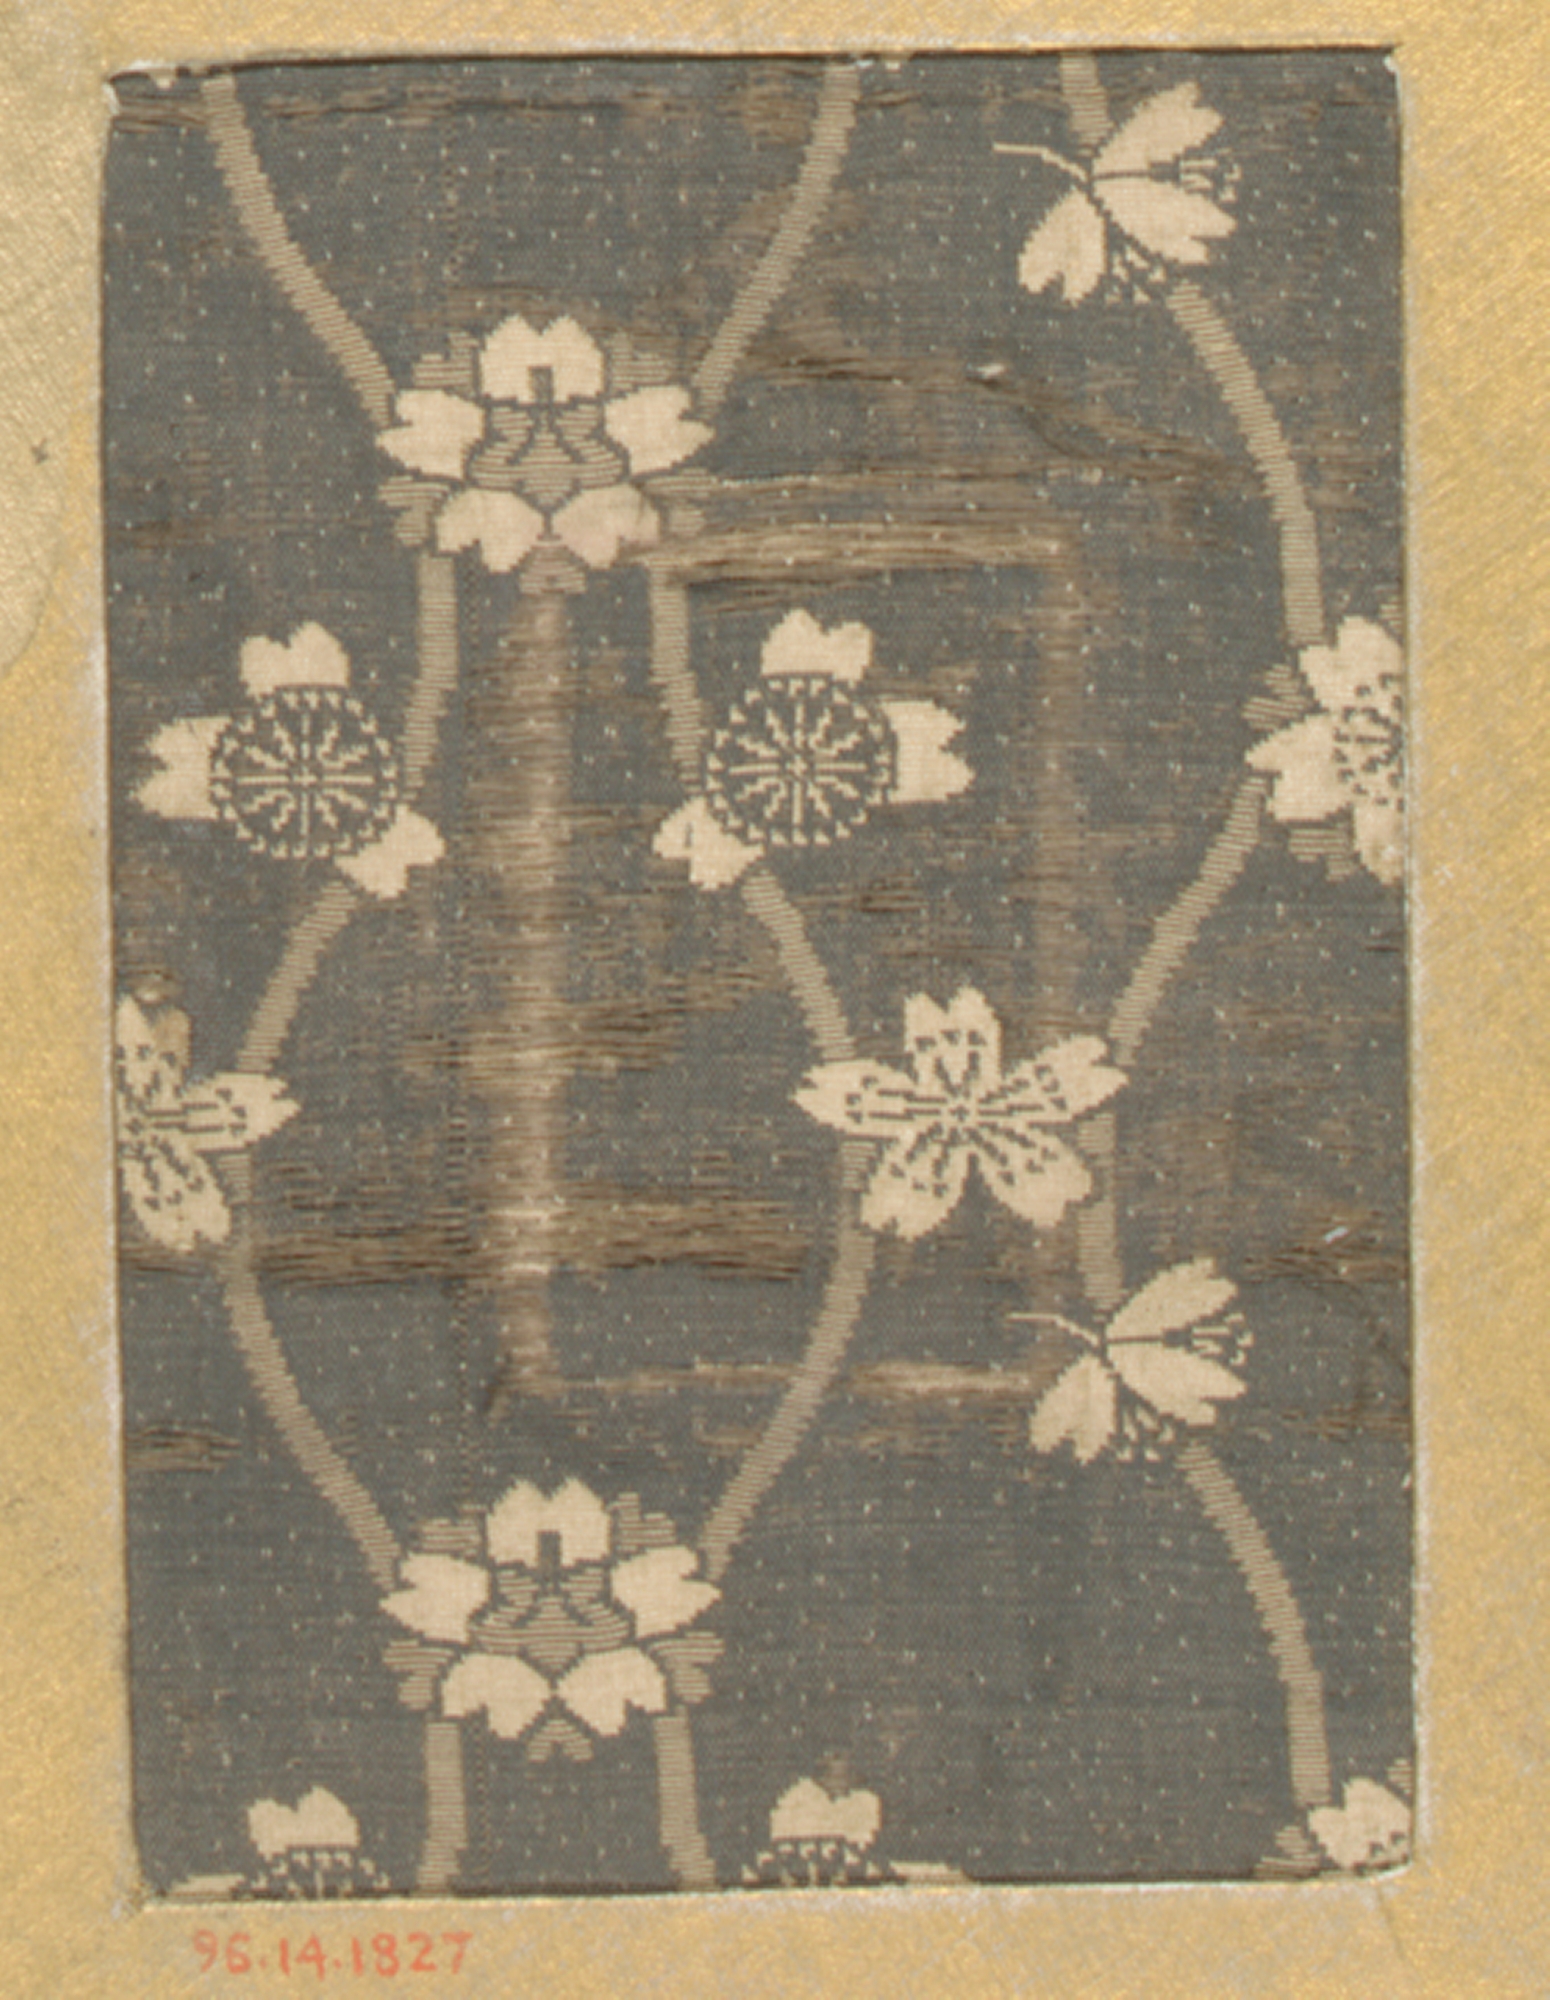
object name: piece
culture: japanese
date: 1701-1900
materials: silk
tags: flowers